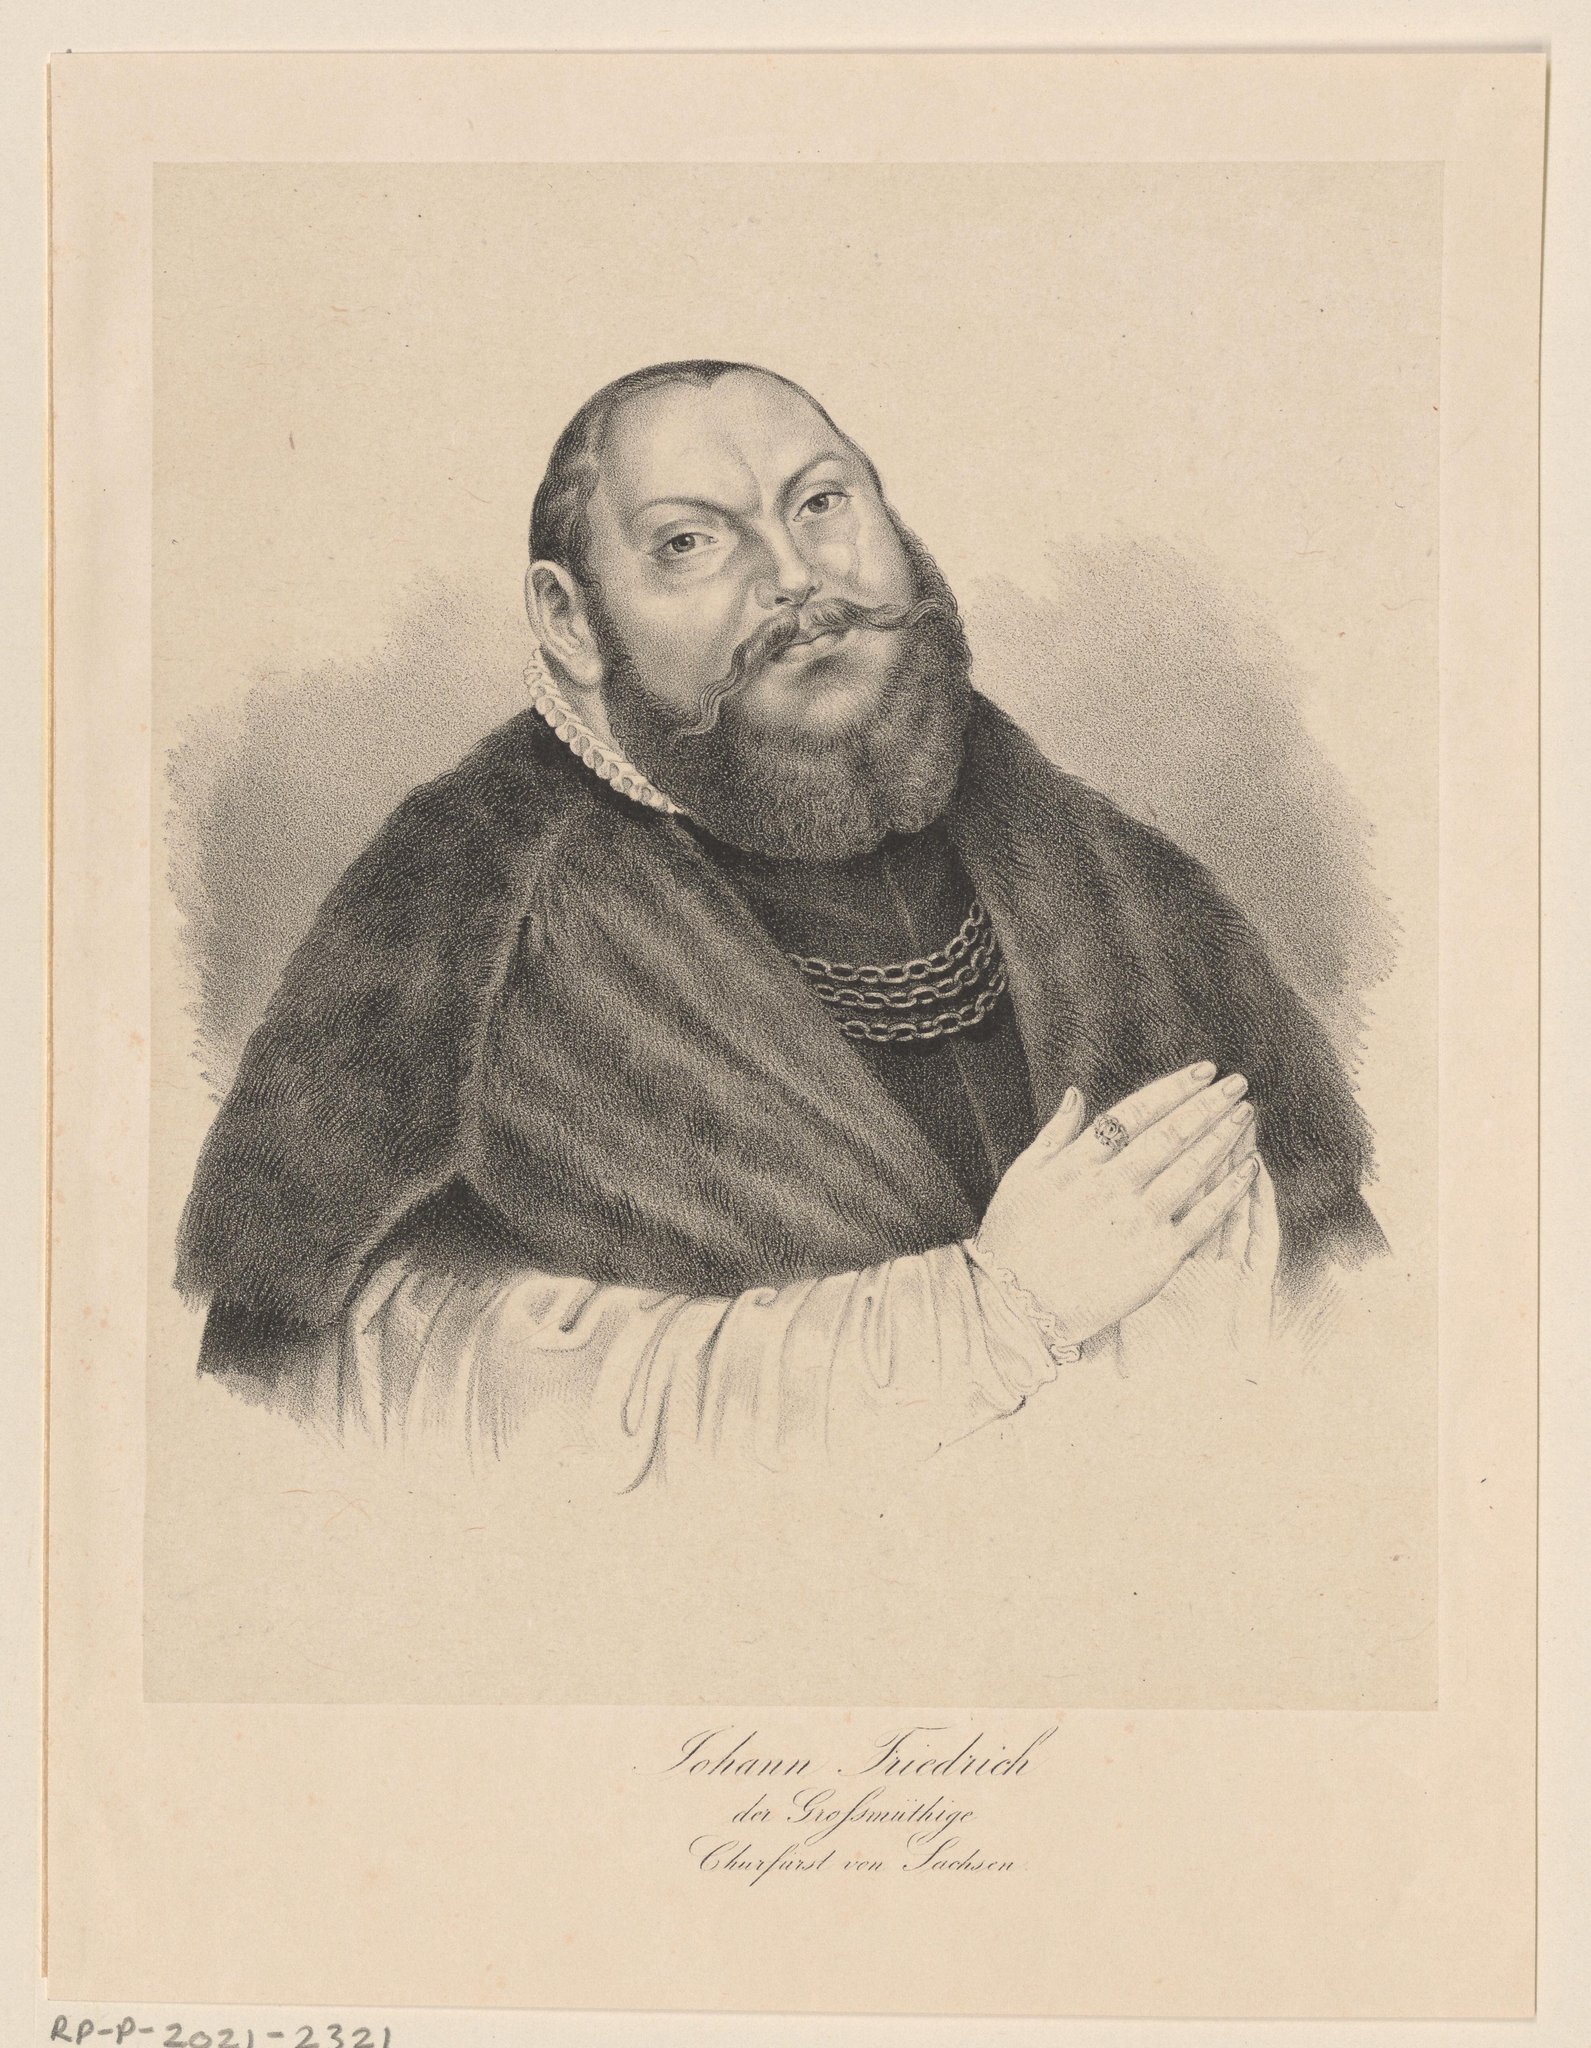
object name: print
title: Portret van Johan Frederik I, keurvorst van Saksen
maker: Anonymous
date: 1800-1899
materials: paper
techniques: lithograph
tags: historical persons, ruler, sovereign